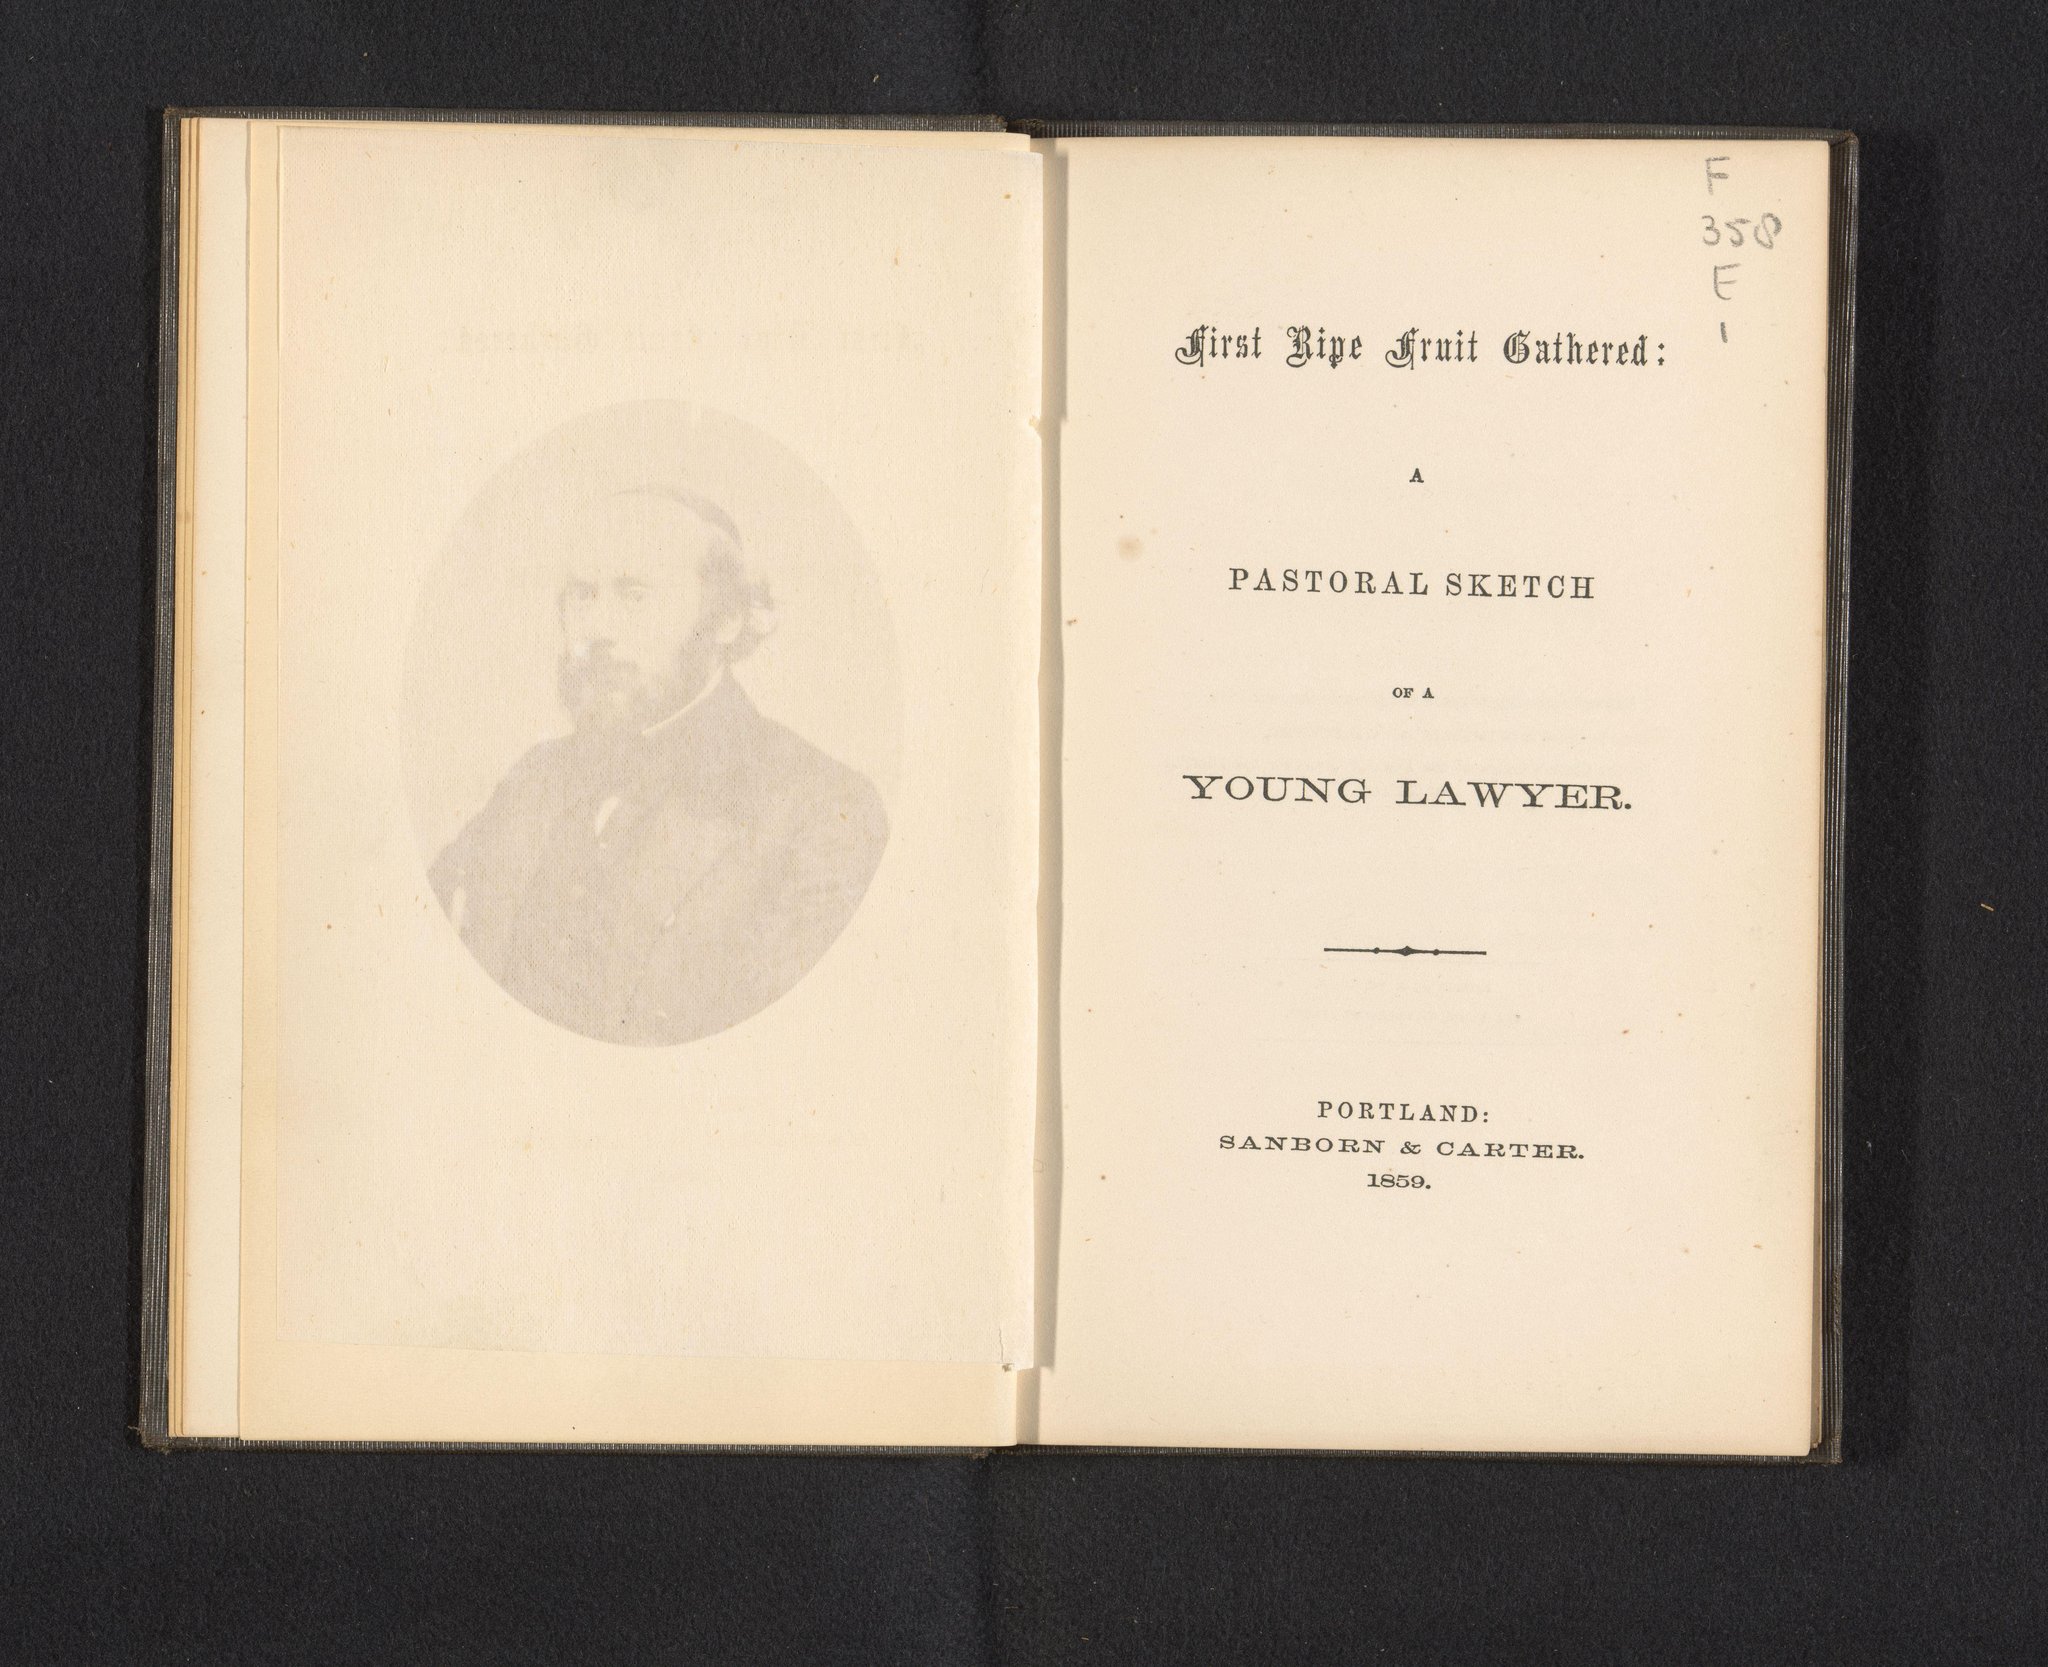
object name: page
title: Portret van J.W. Chickering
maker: Anonymous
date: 1854-1859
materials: photographic support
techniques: albumen print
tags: clergyman, john white chickering, portrait of a writer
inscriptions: inscription: ‘Philip Henry Brown’